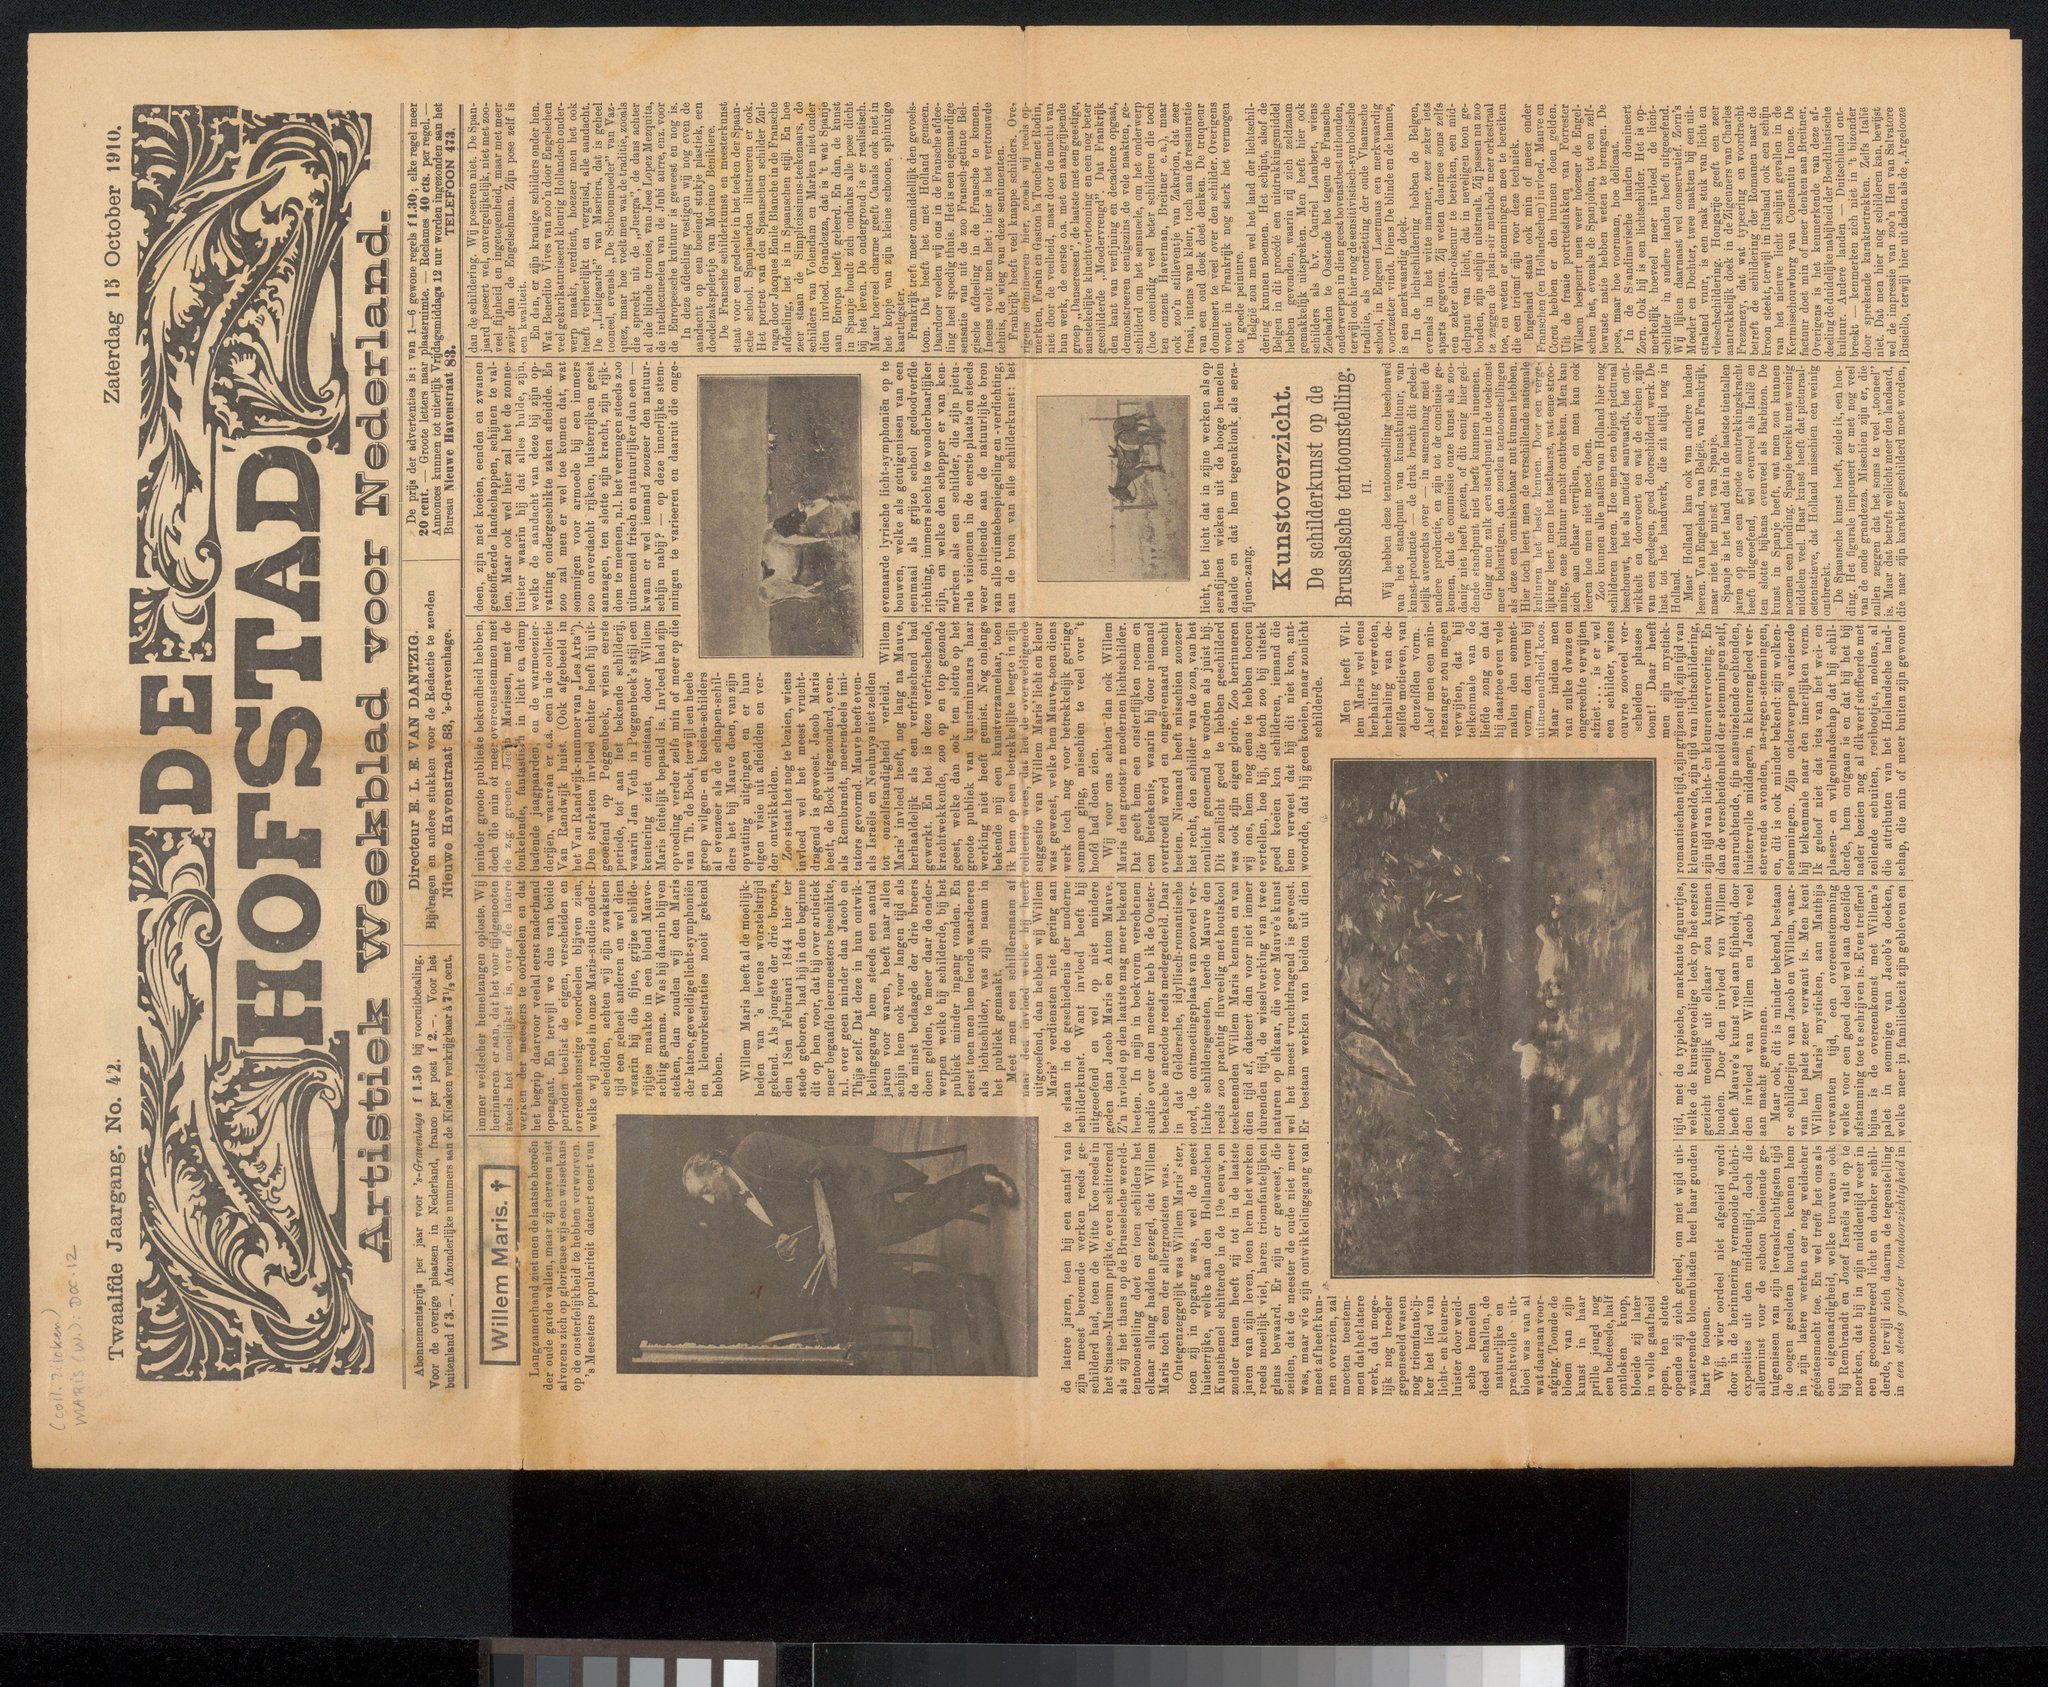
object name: newspaper clipping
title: Krantenknipsel uit archief Philip Zilcken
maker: Anonymous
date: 1910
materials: paper, ink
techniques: printing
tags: willem maris, the hague, painter, draughtsman, philip zilcken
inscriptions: collector's mark: ‘RPK’